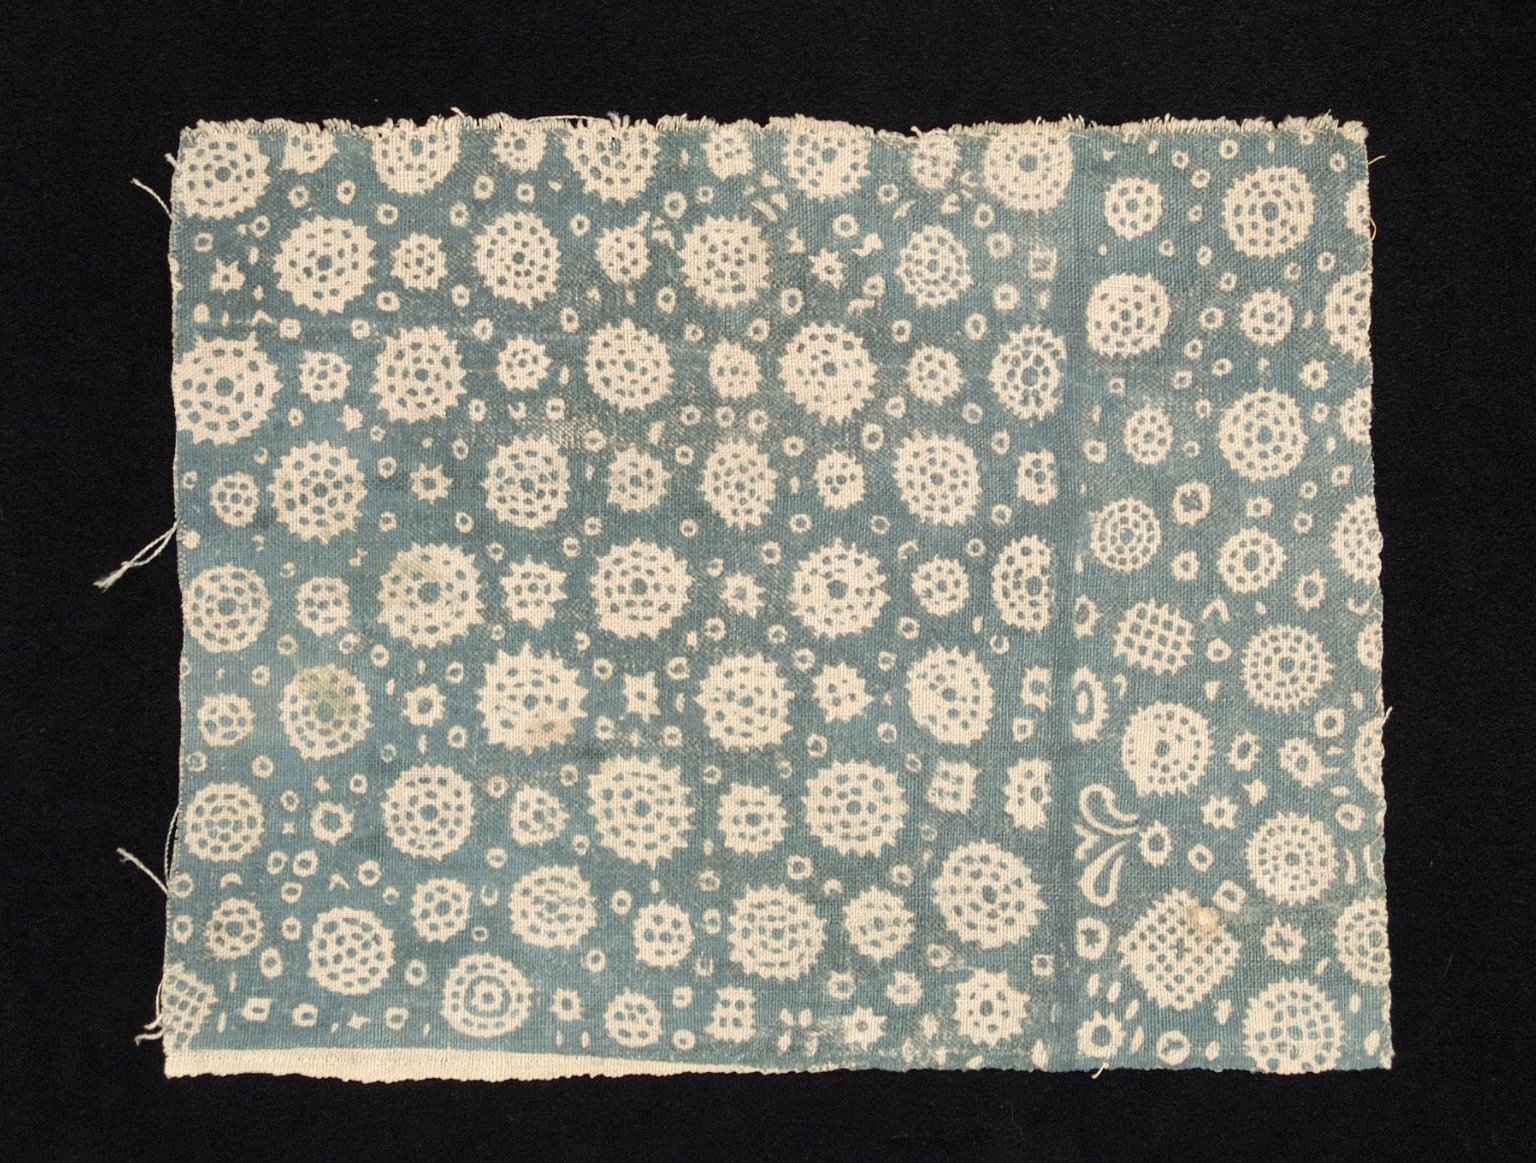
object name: textile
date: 1700-1899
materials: linen